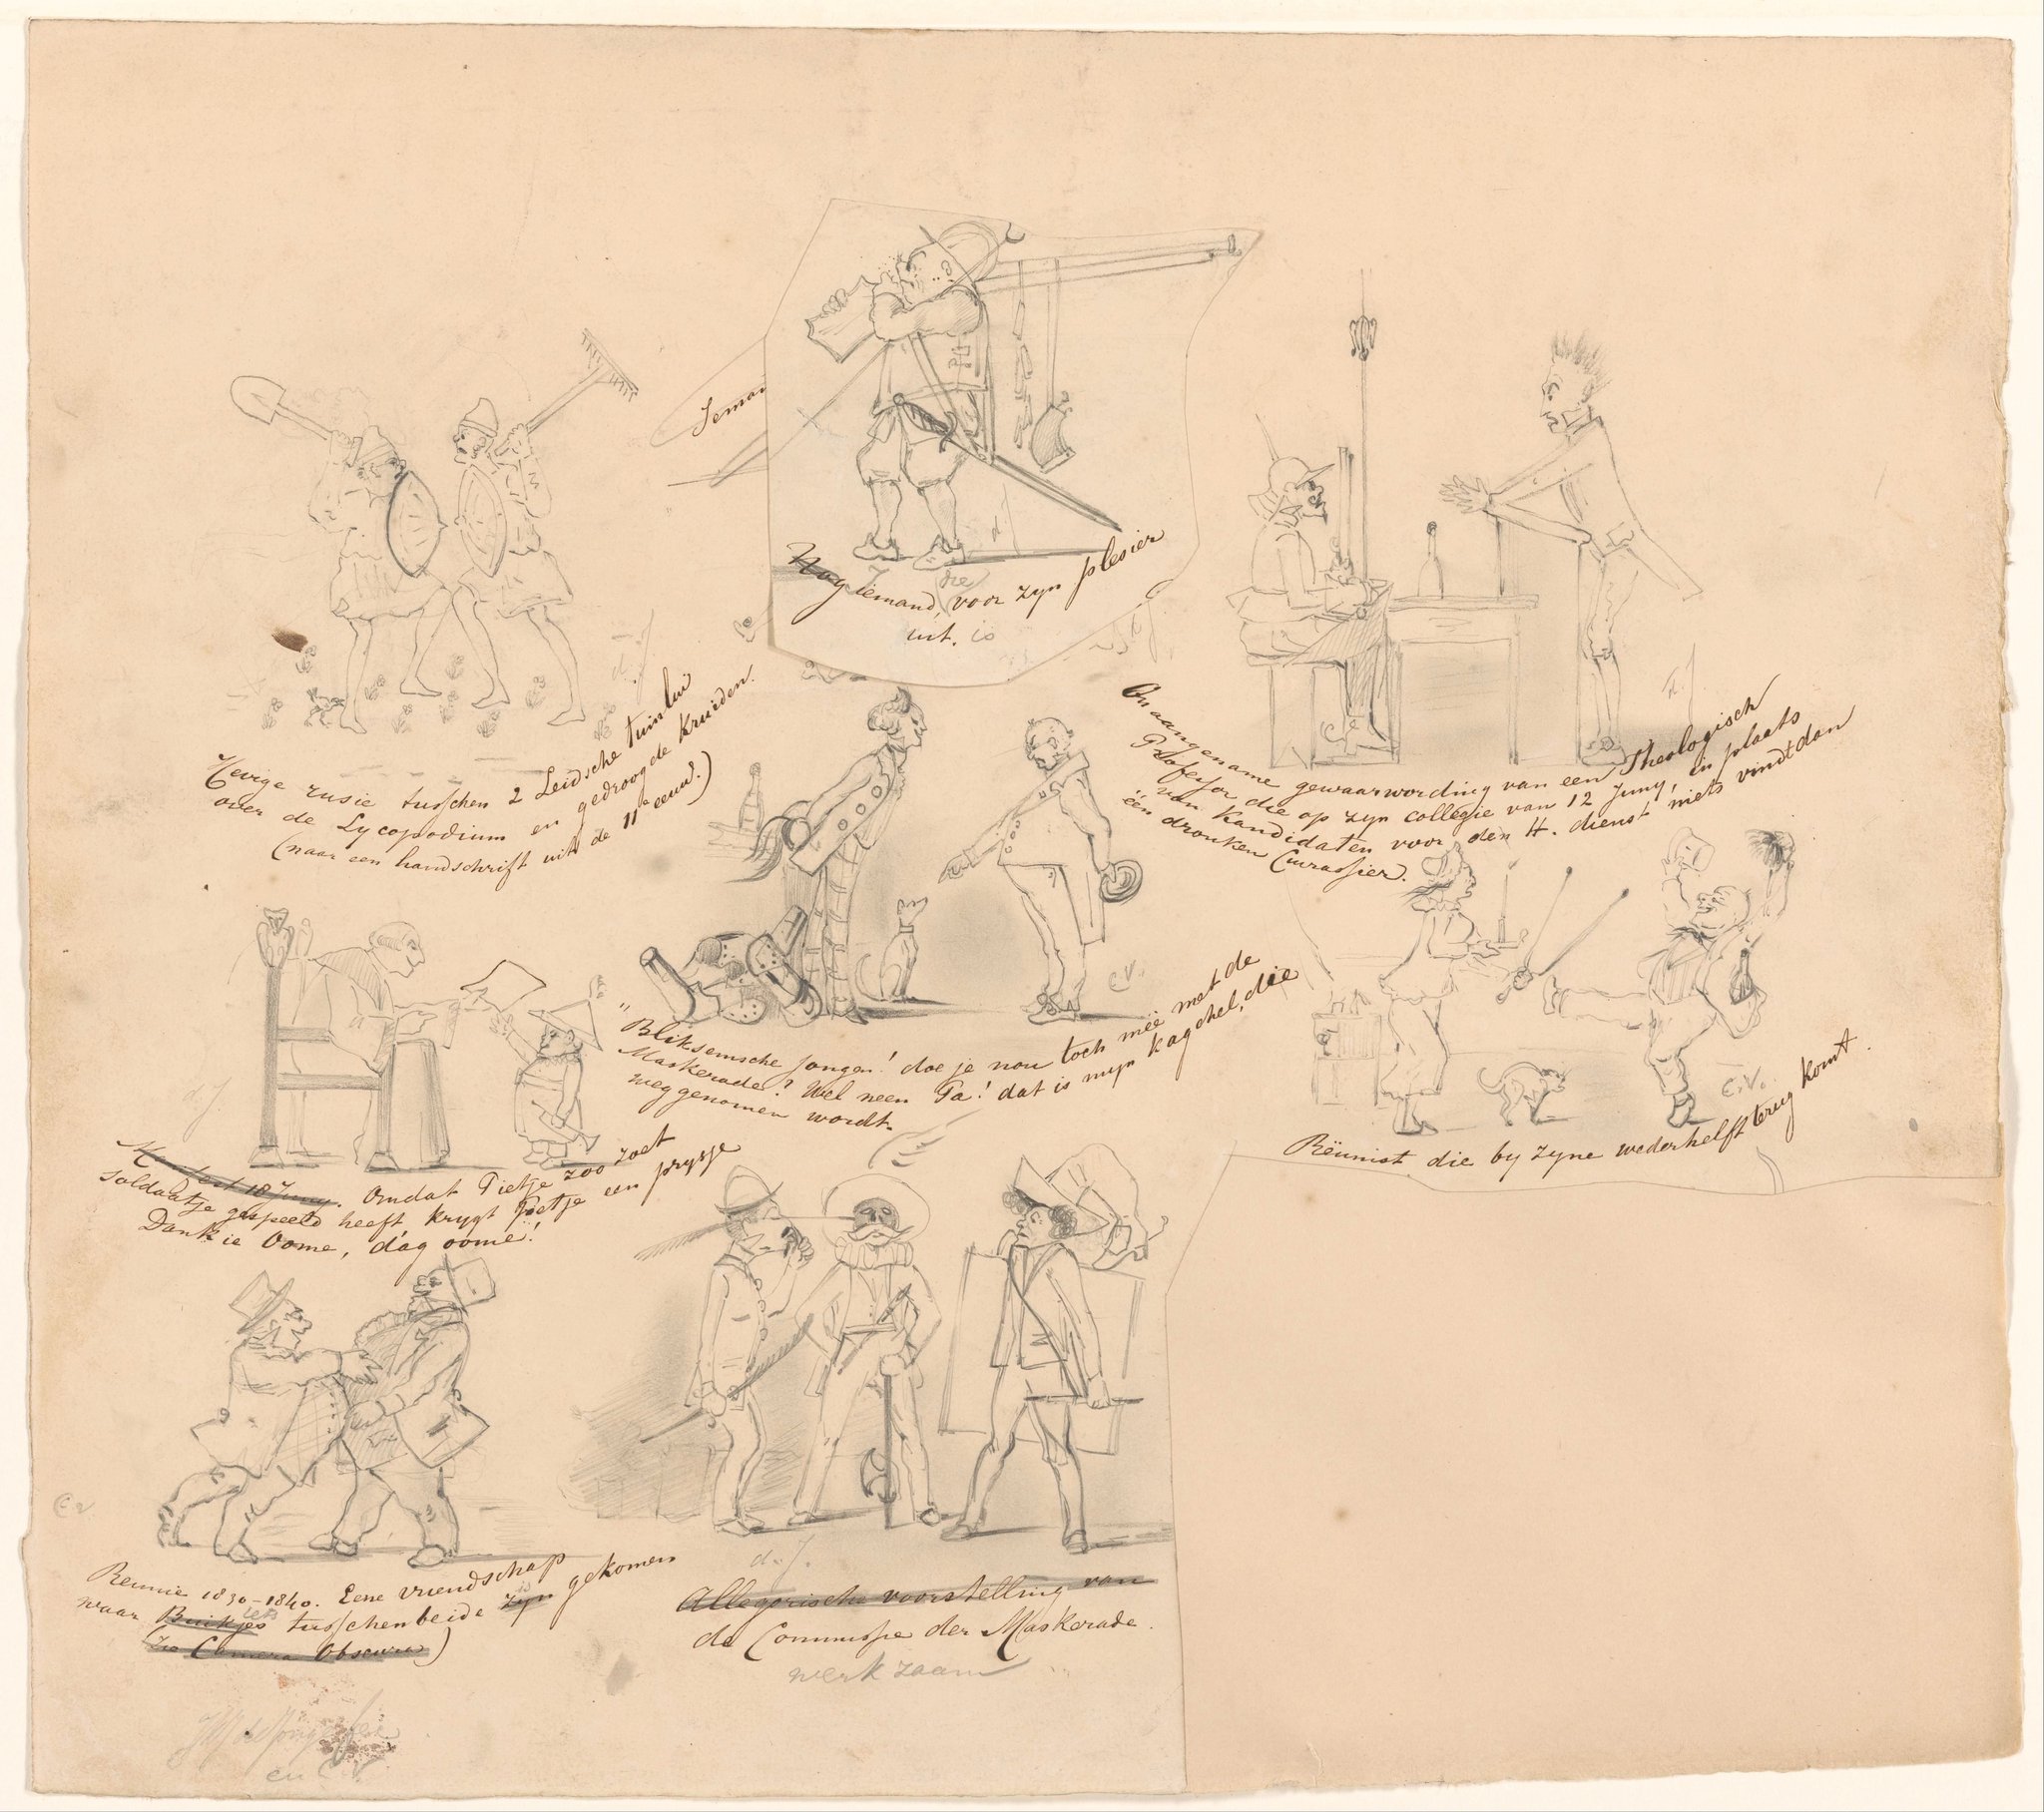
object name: design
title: Ontwerp voor Almanakprent: acht voorstellingen die verband houden met de Leidse Maskerade van 1850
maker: carel vosmaer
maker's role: draughtsman, print maker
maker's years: 1826-1888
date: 1836-1888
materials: ink, paper, pencil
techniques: pen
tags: names of organizations, companies, trade unions, etc., university, student life, leiden